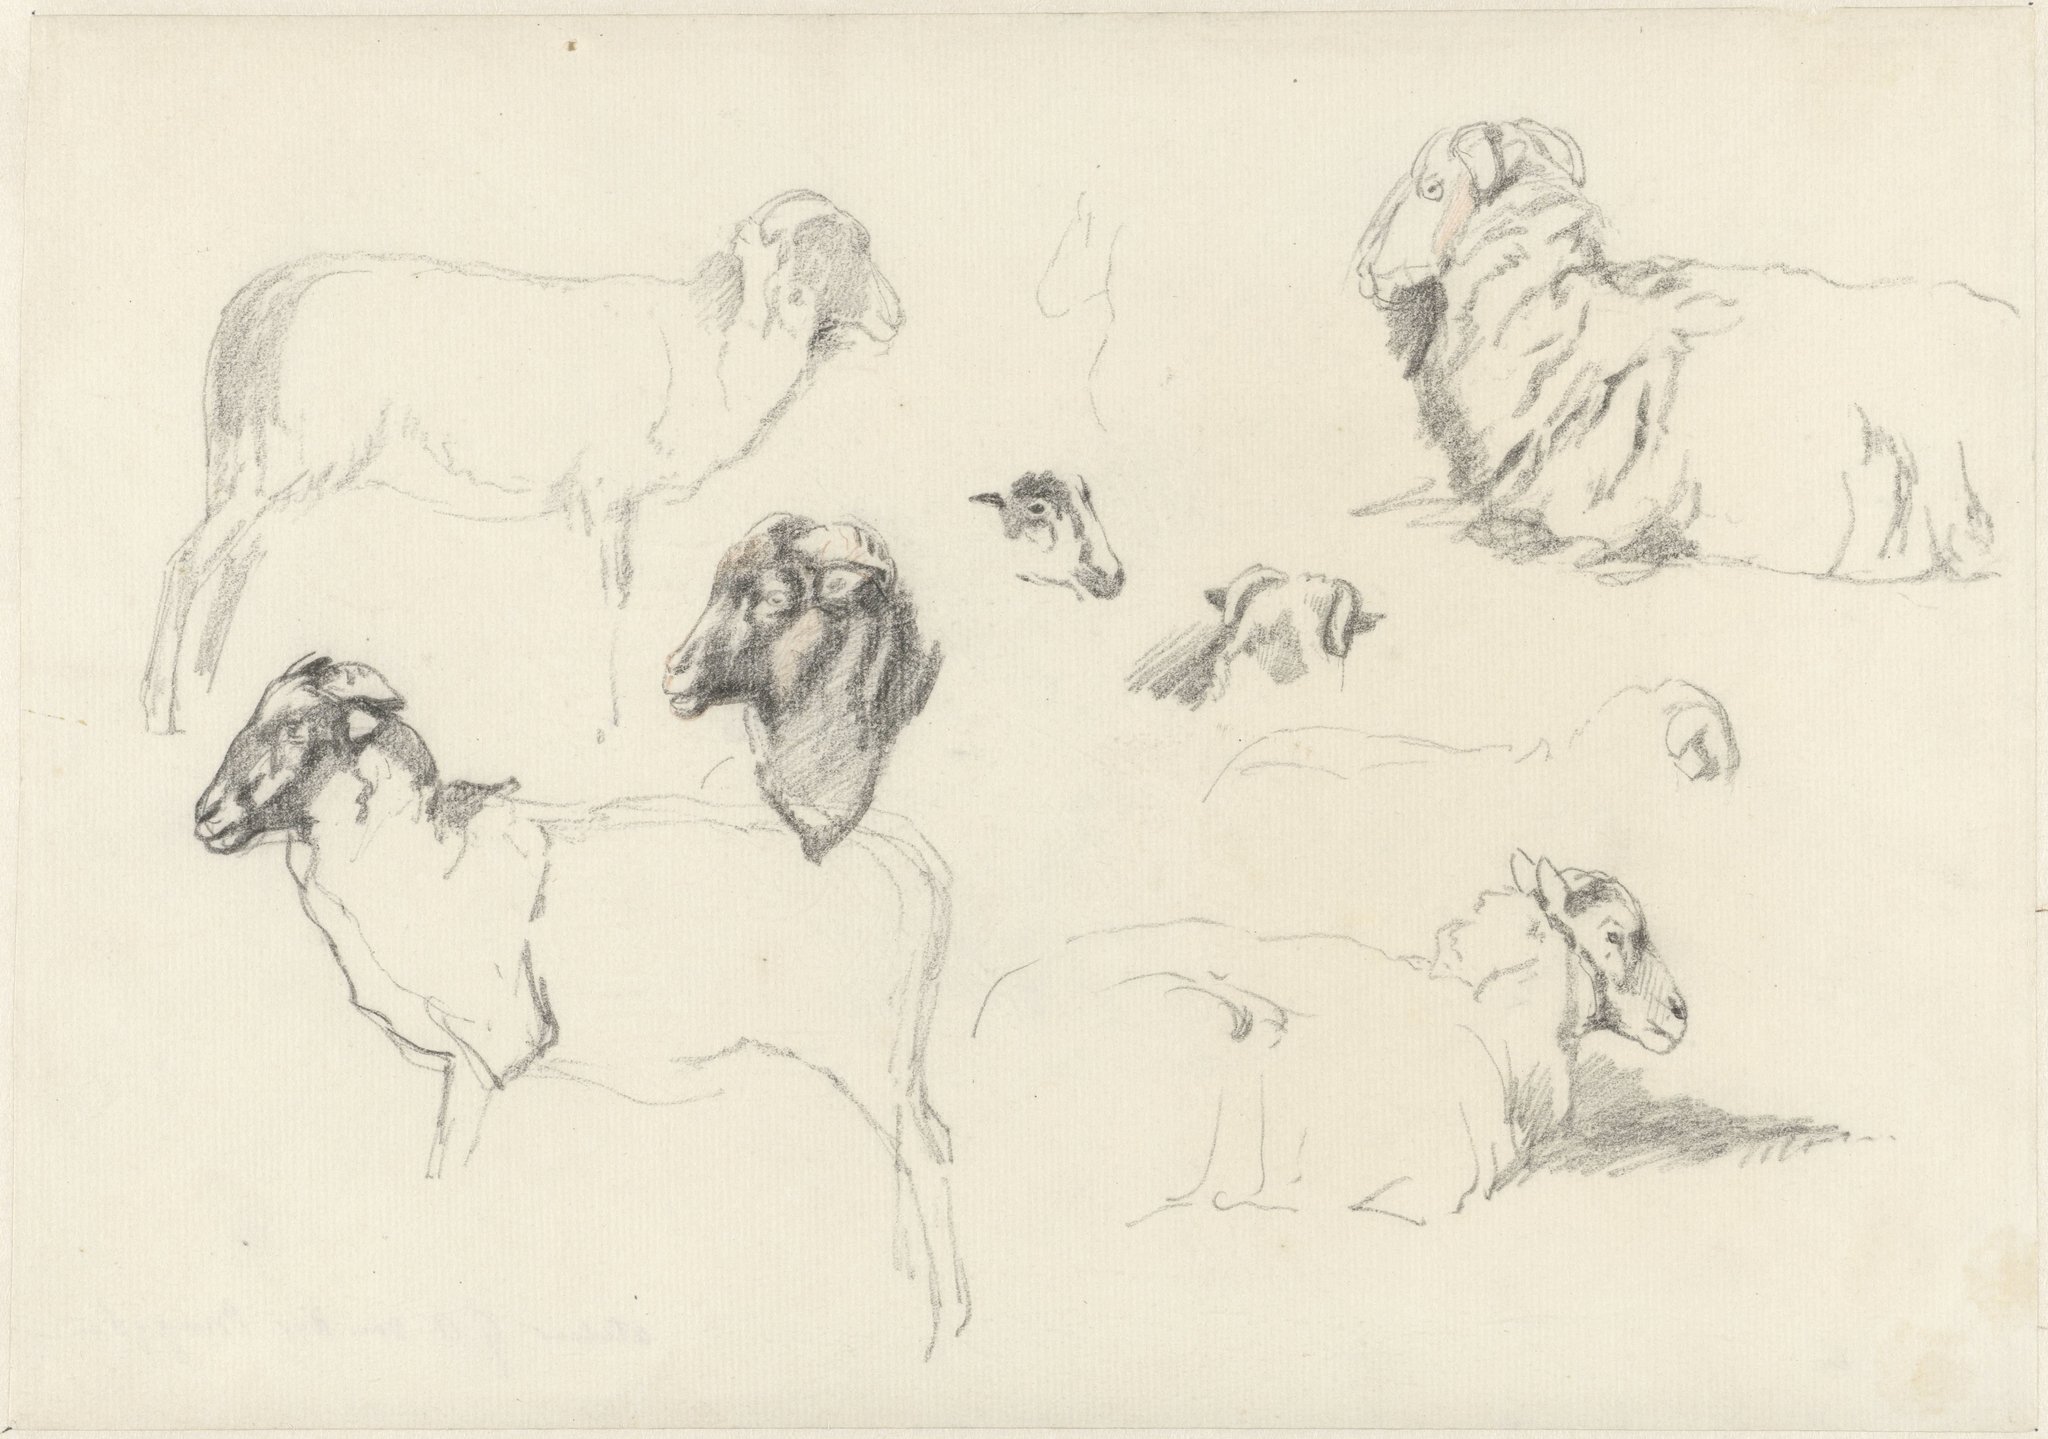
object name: drawing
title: Studies van schapen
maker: guillaume anne van der brugghen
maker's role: draughtsman, print maker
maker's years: 1812-1891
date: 1821-1891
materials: chalk, paper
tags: sheep